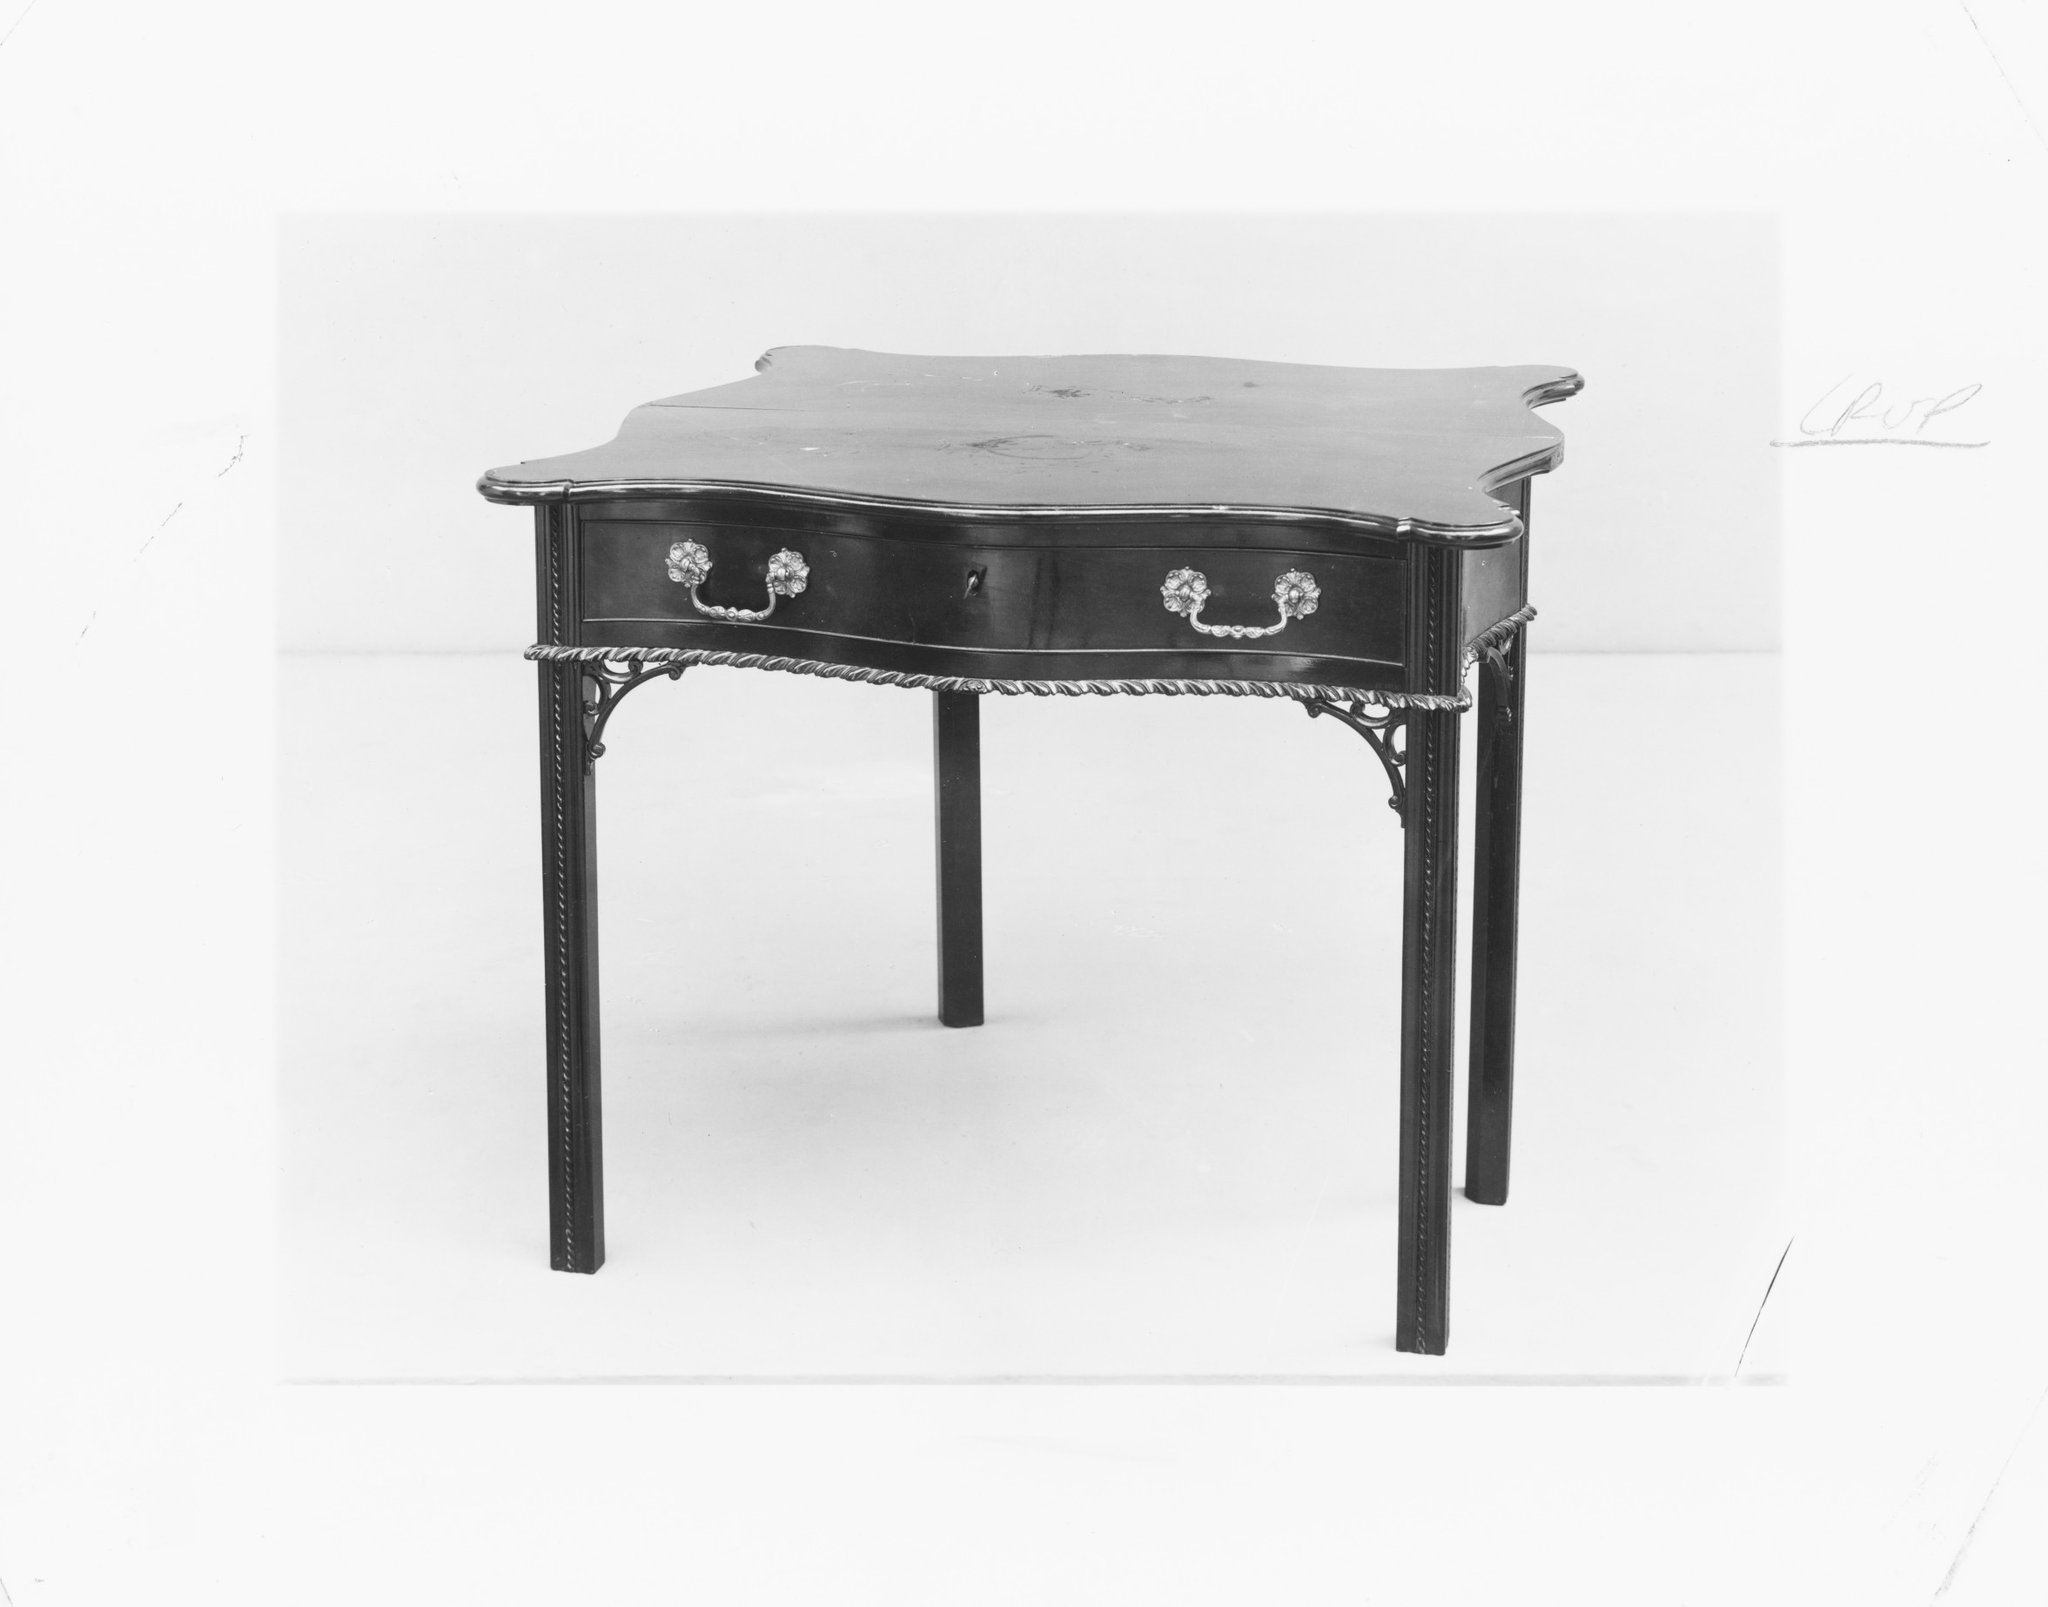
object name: card table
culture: american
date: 1765-1790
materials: wood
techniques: veneering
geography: united states